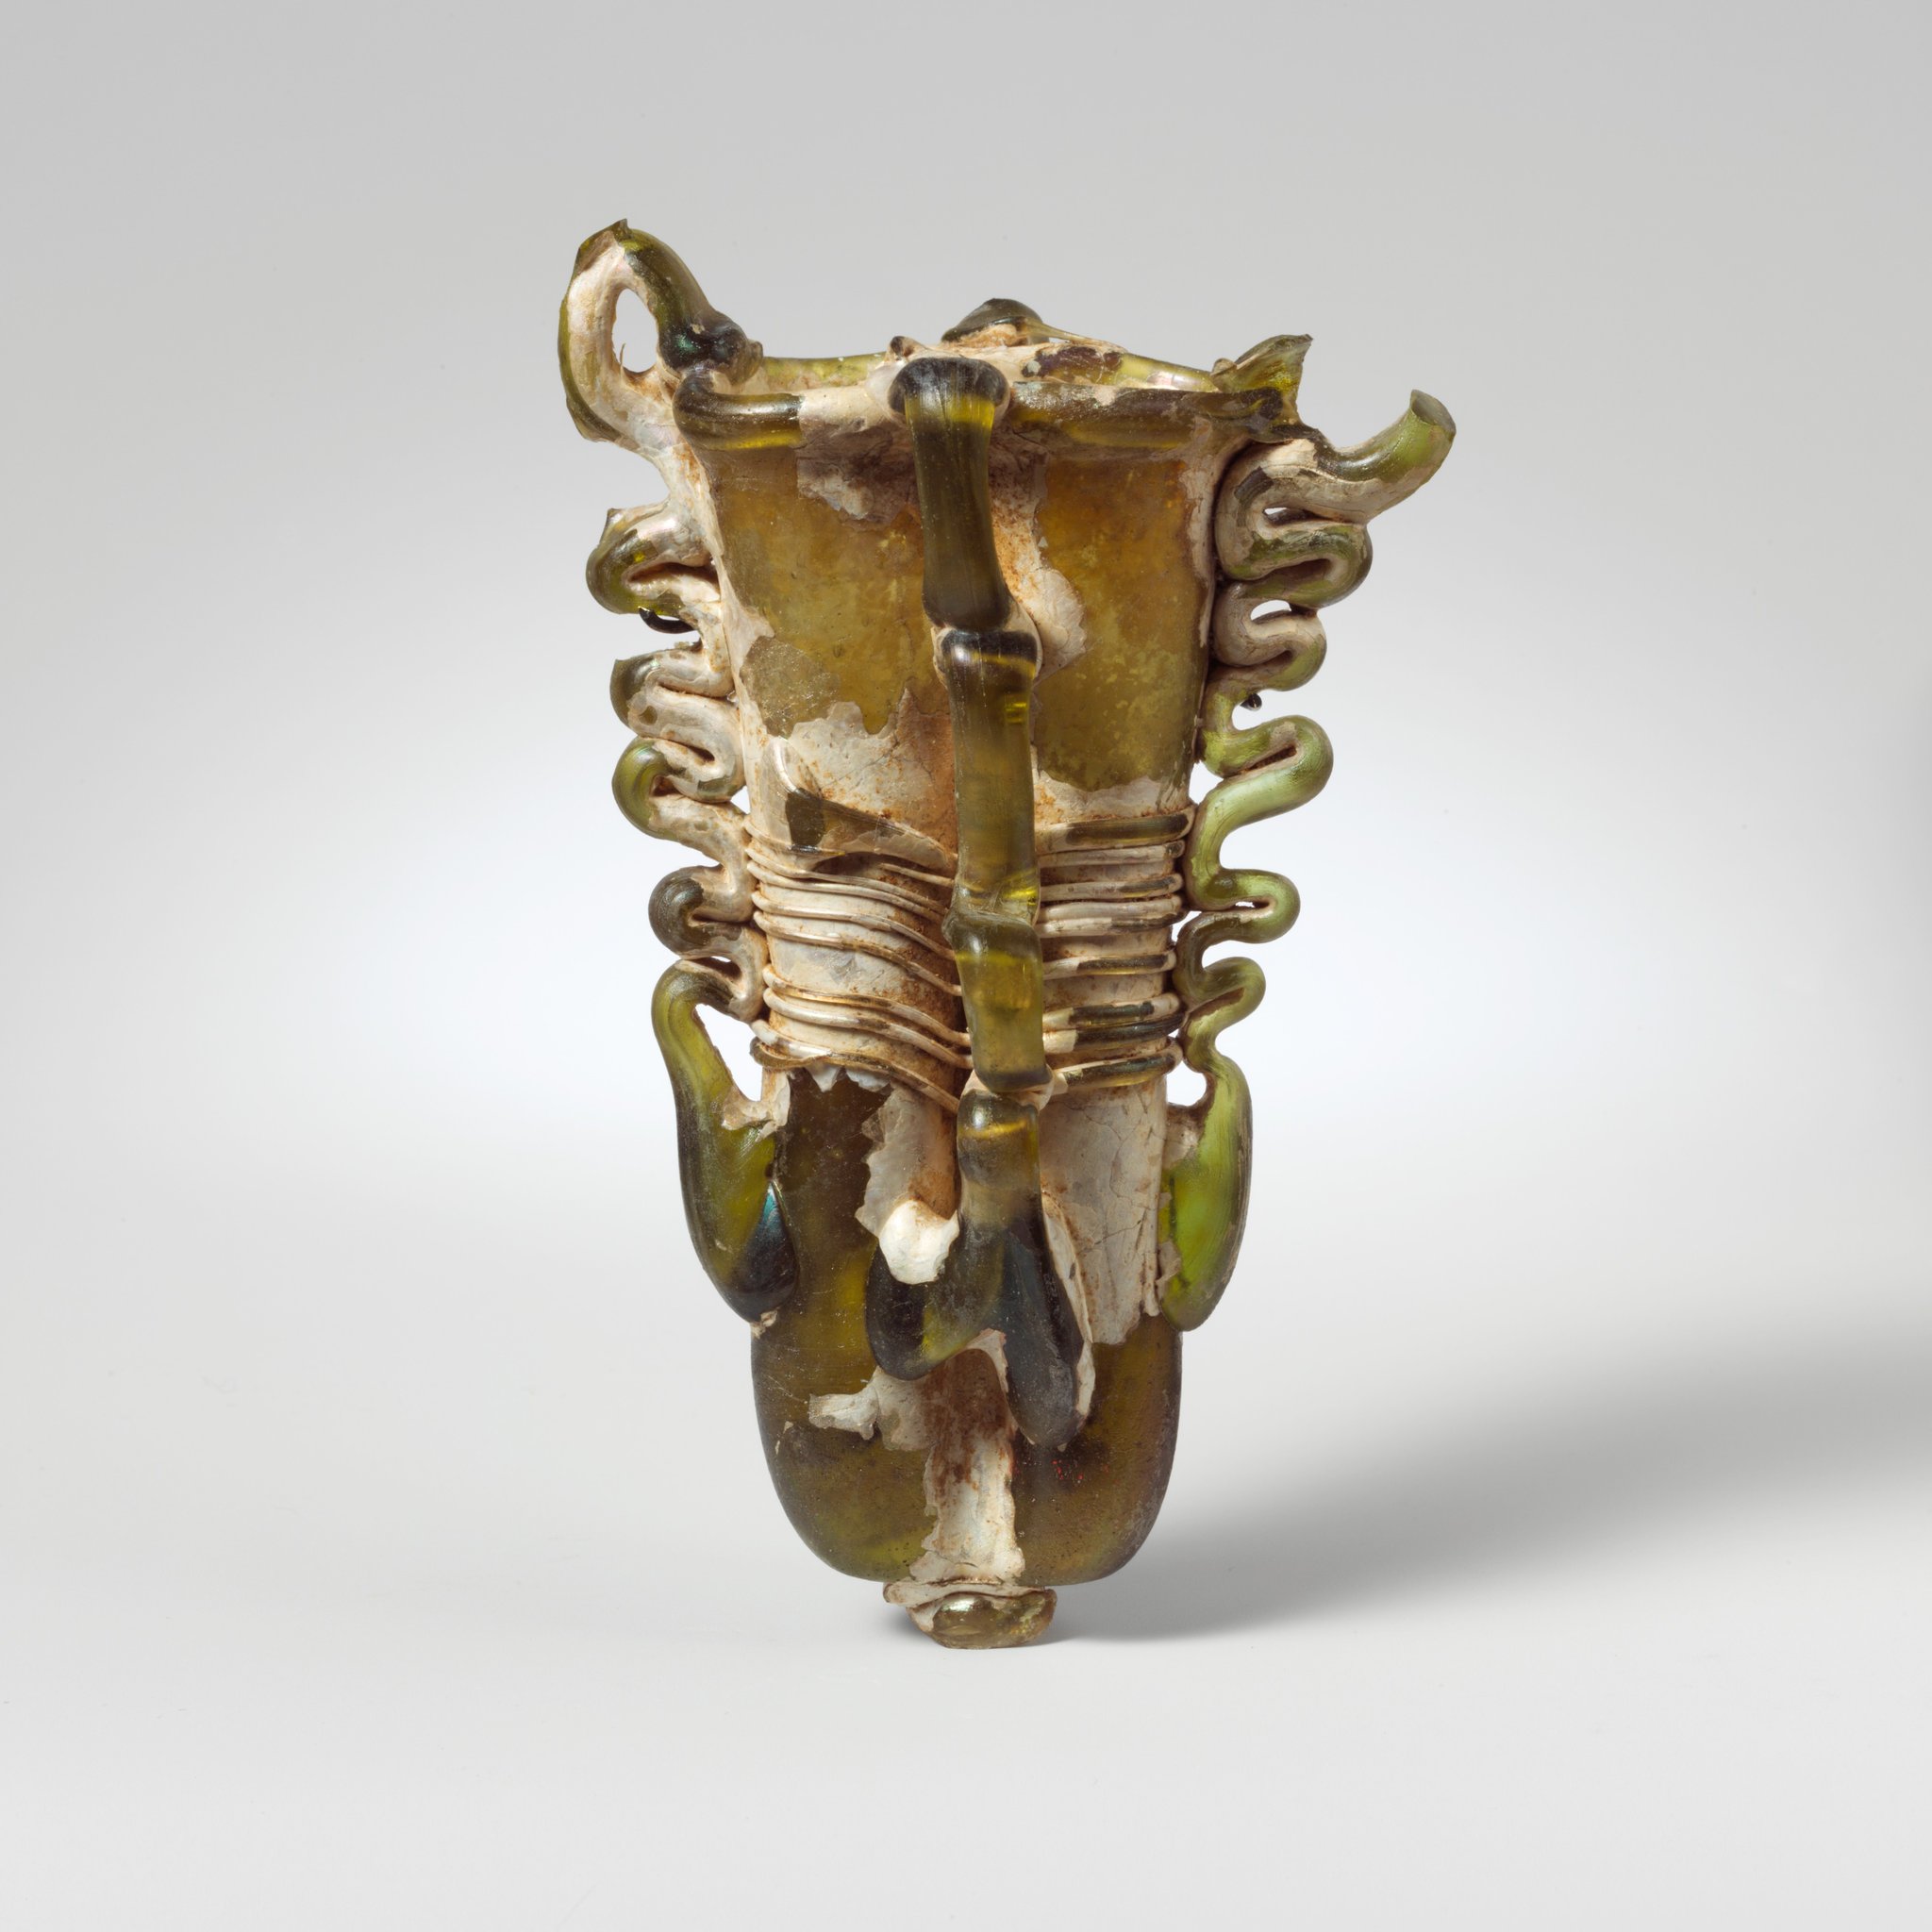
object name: cosmetic flask, double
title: Glass double cosmetic flask (kohl tube)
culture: roman, syrian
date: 301-400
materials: glass